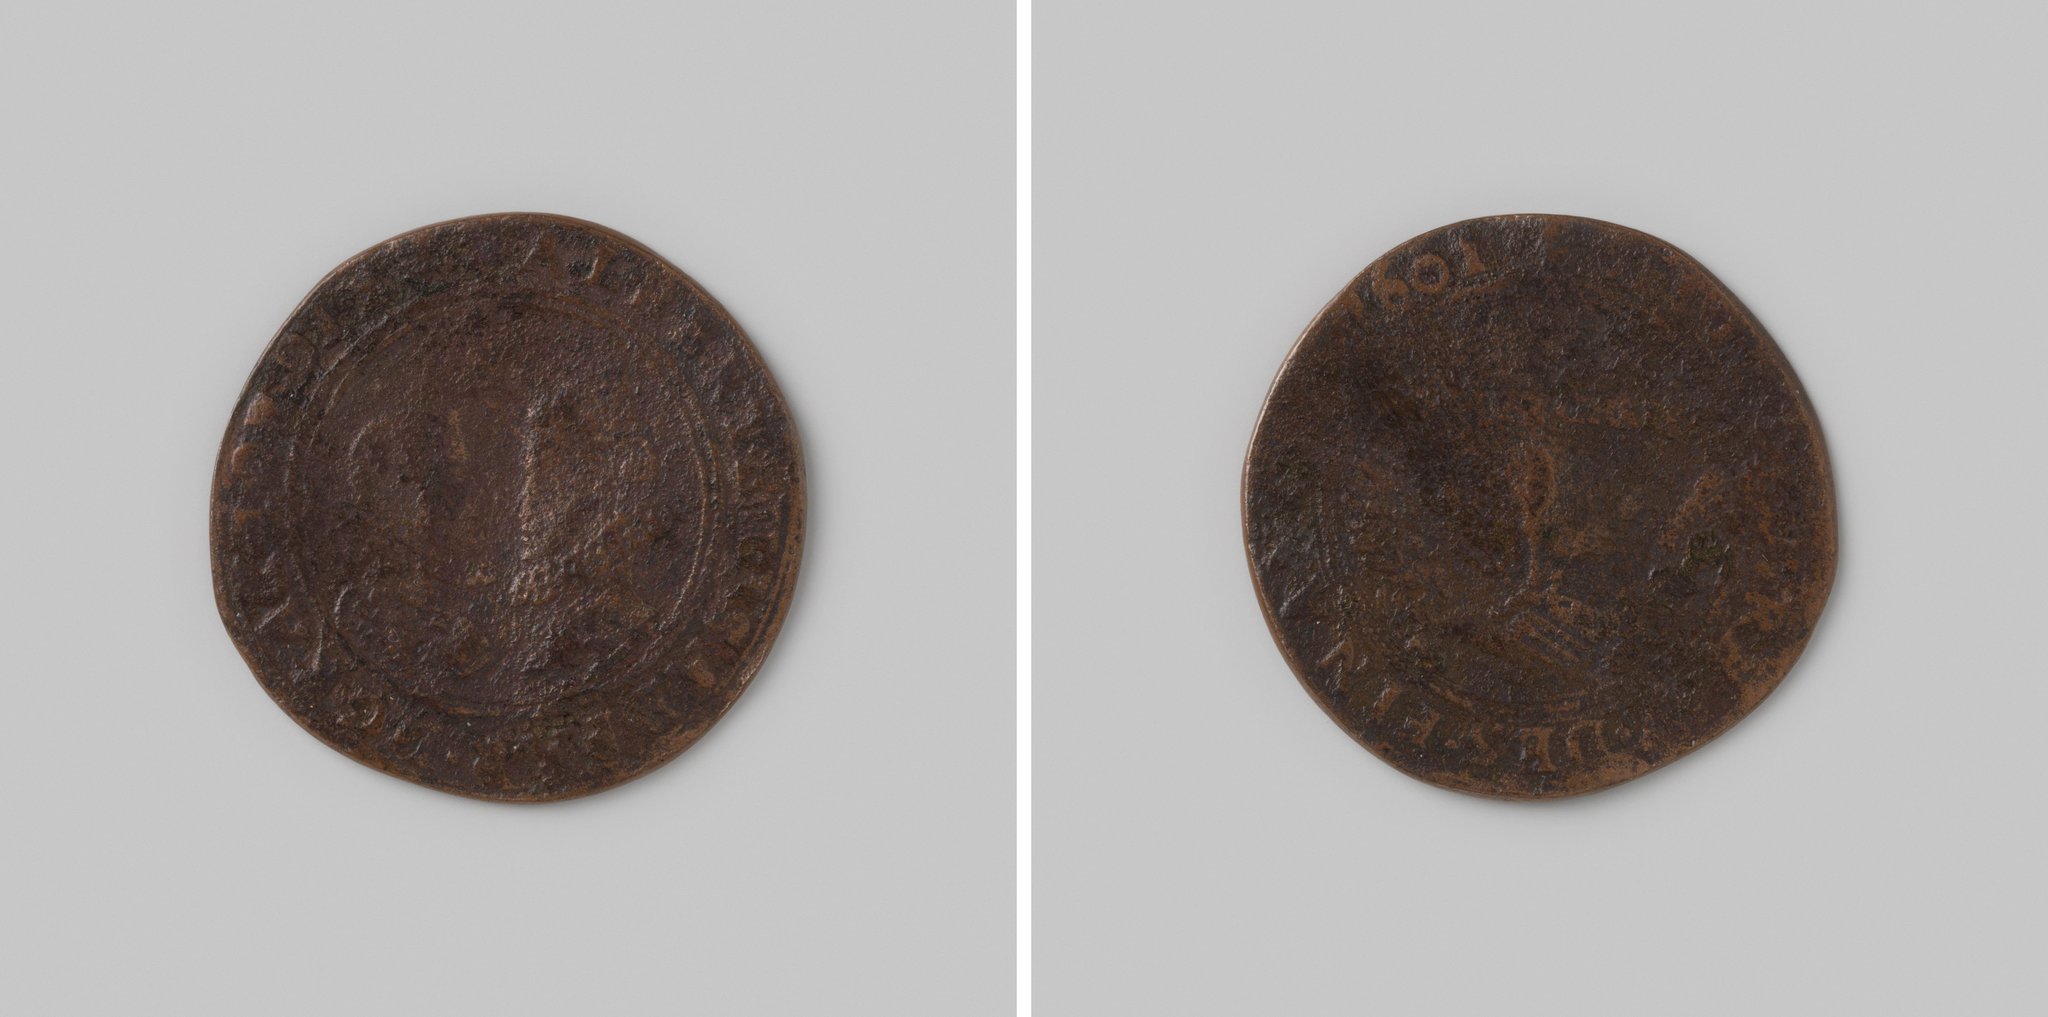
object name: jeton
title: Rekenpenning uit Antwerpen voor het Bureau van Financien op het beleg van Ostende door de Spaanse troepen 1601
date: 1601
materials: copper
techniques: striking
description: Koperen penning, op de voorzijde de elkaar toegewende borstbeelden van Albert en Isabella met omschrift, op de keerzijde twee ineengeslagen gevleugelde handen waarachter korenaren, met tekst in het veld en omschrift.